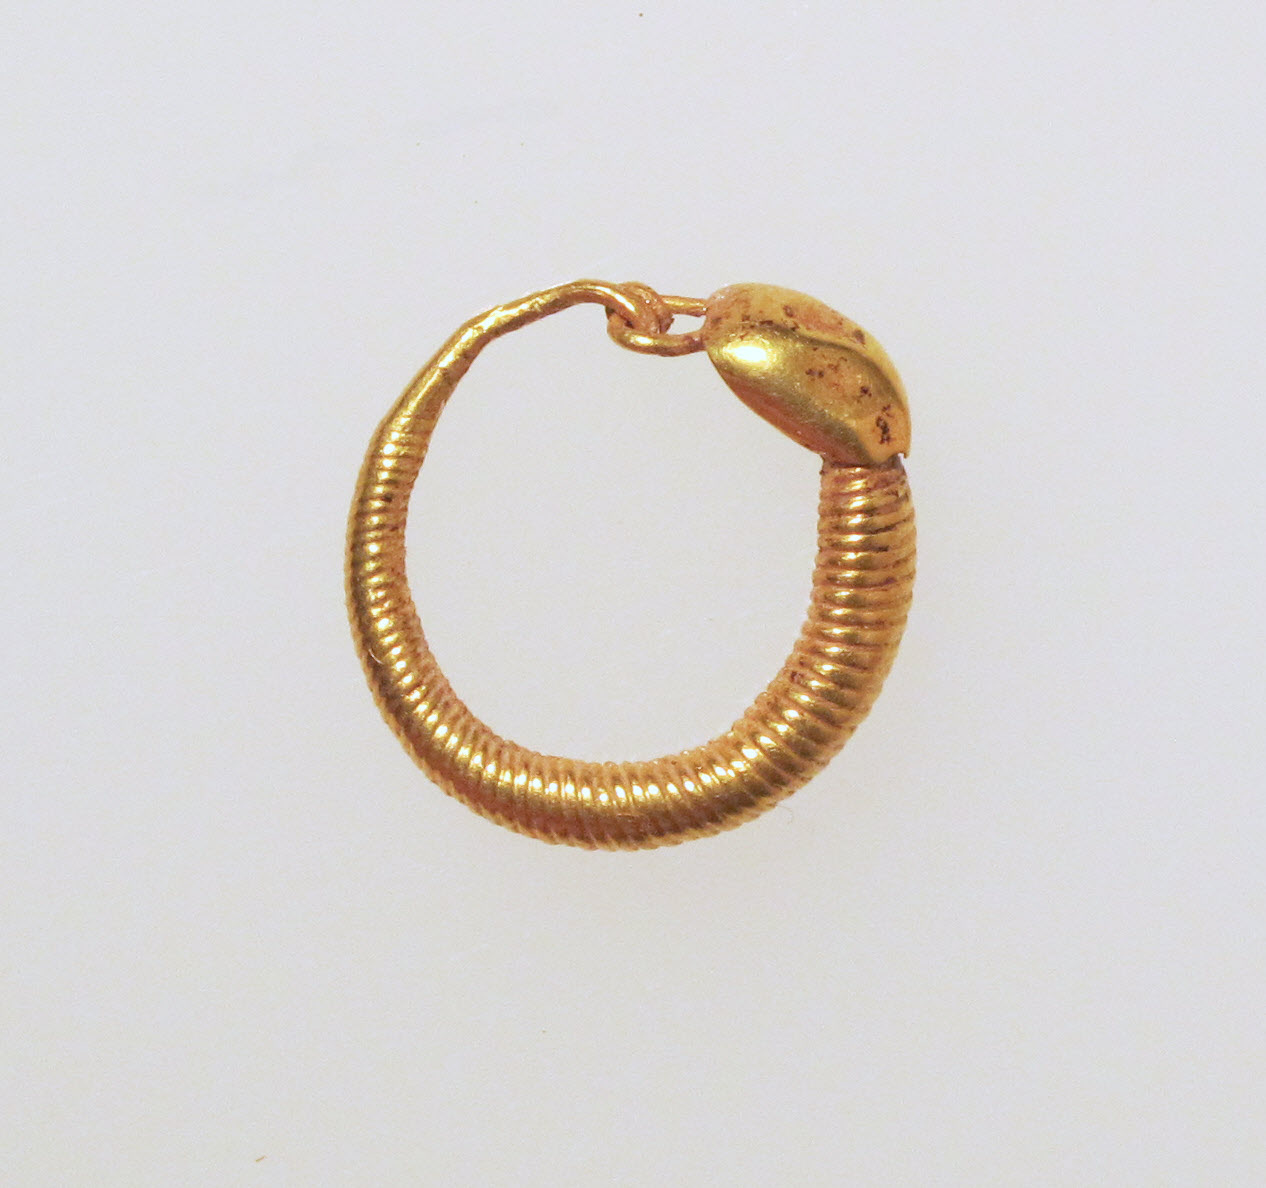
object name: earring with plain loop and disc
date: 7000 BCE-330 CE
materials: gold